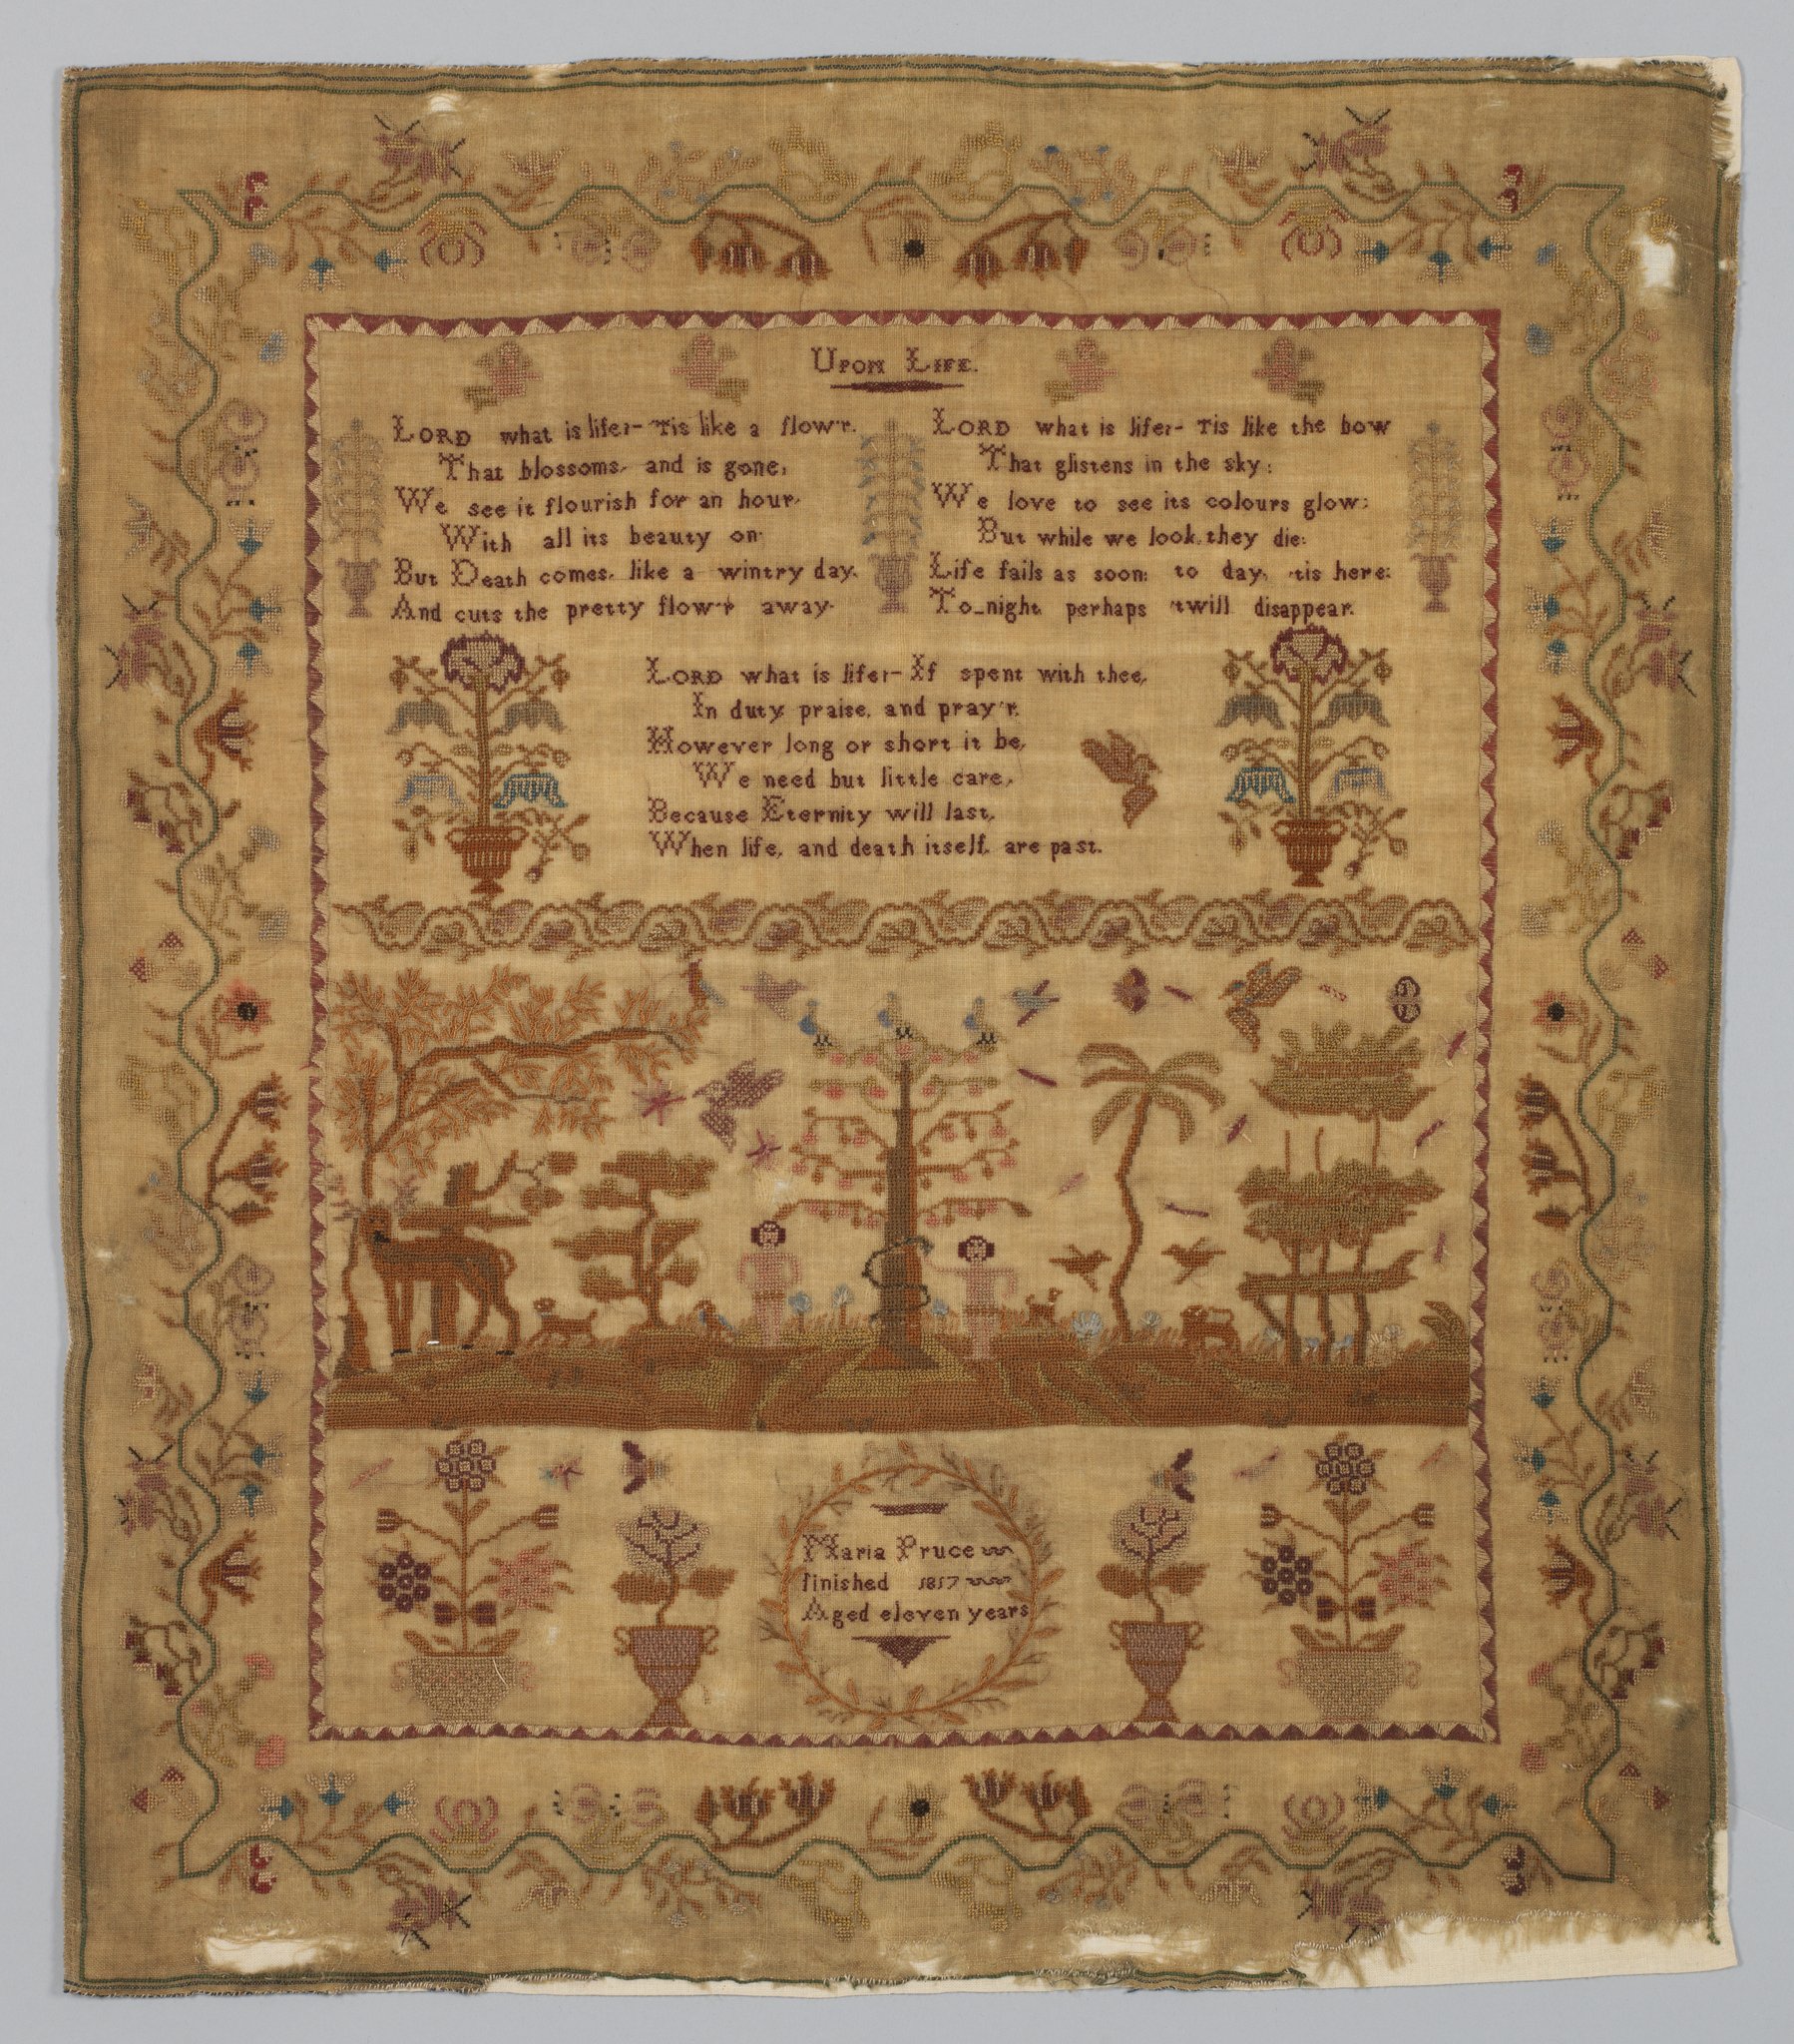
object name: sampler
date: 1817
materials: canvas, silk, wool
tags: animals,birds,flowers,trees